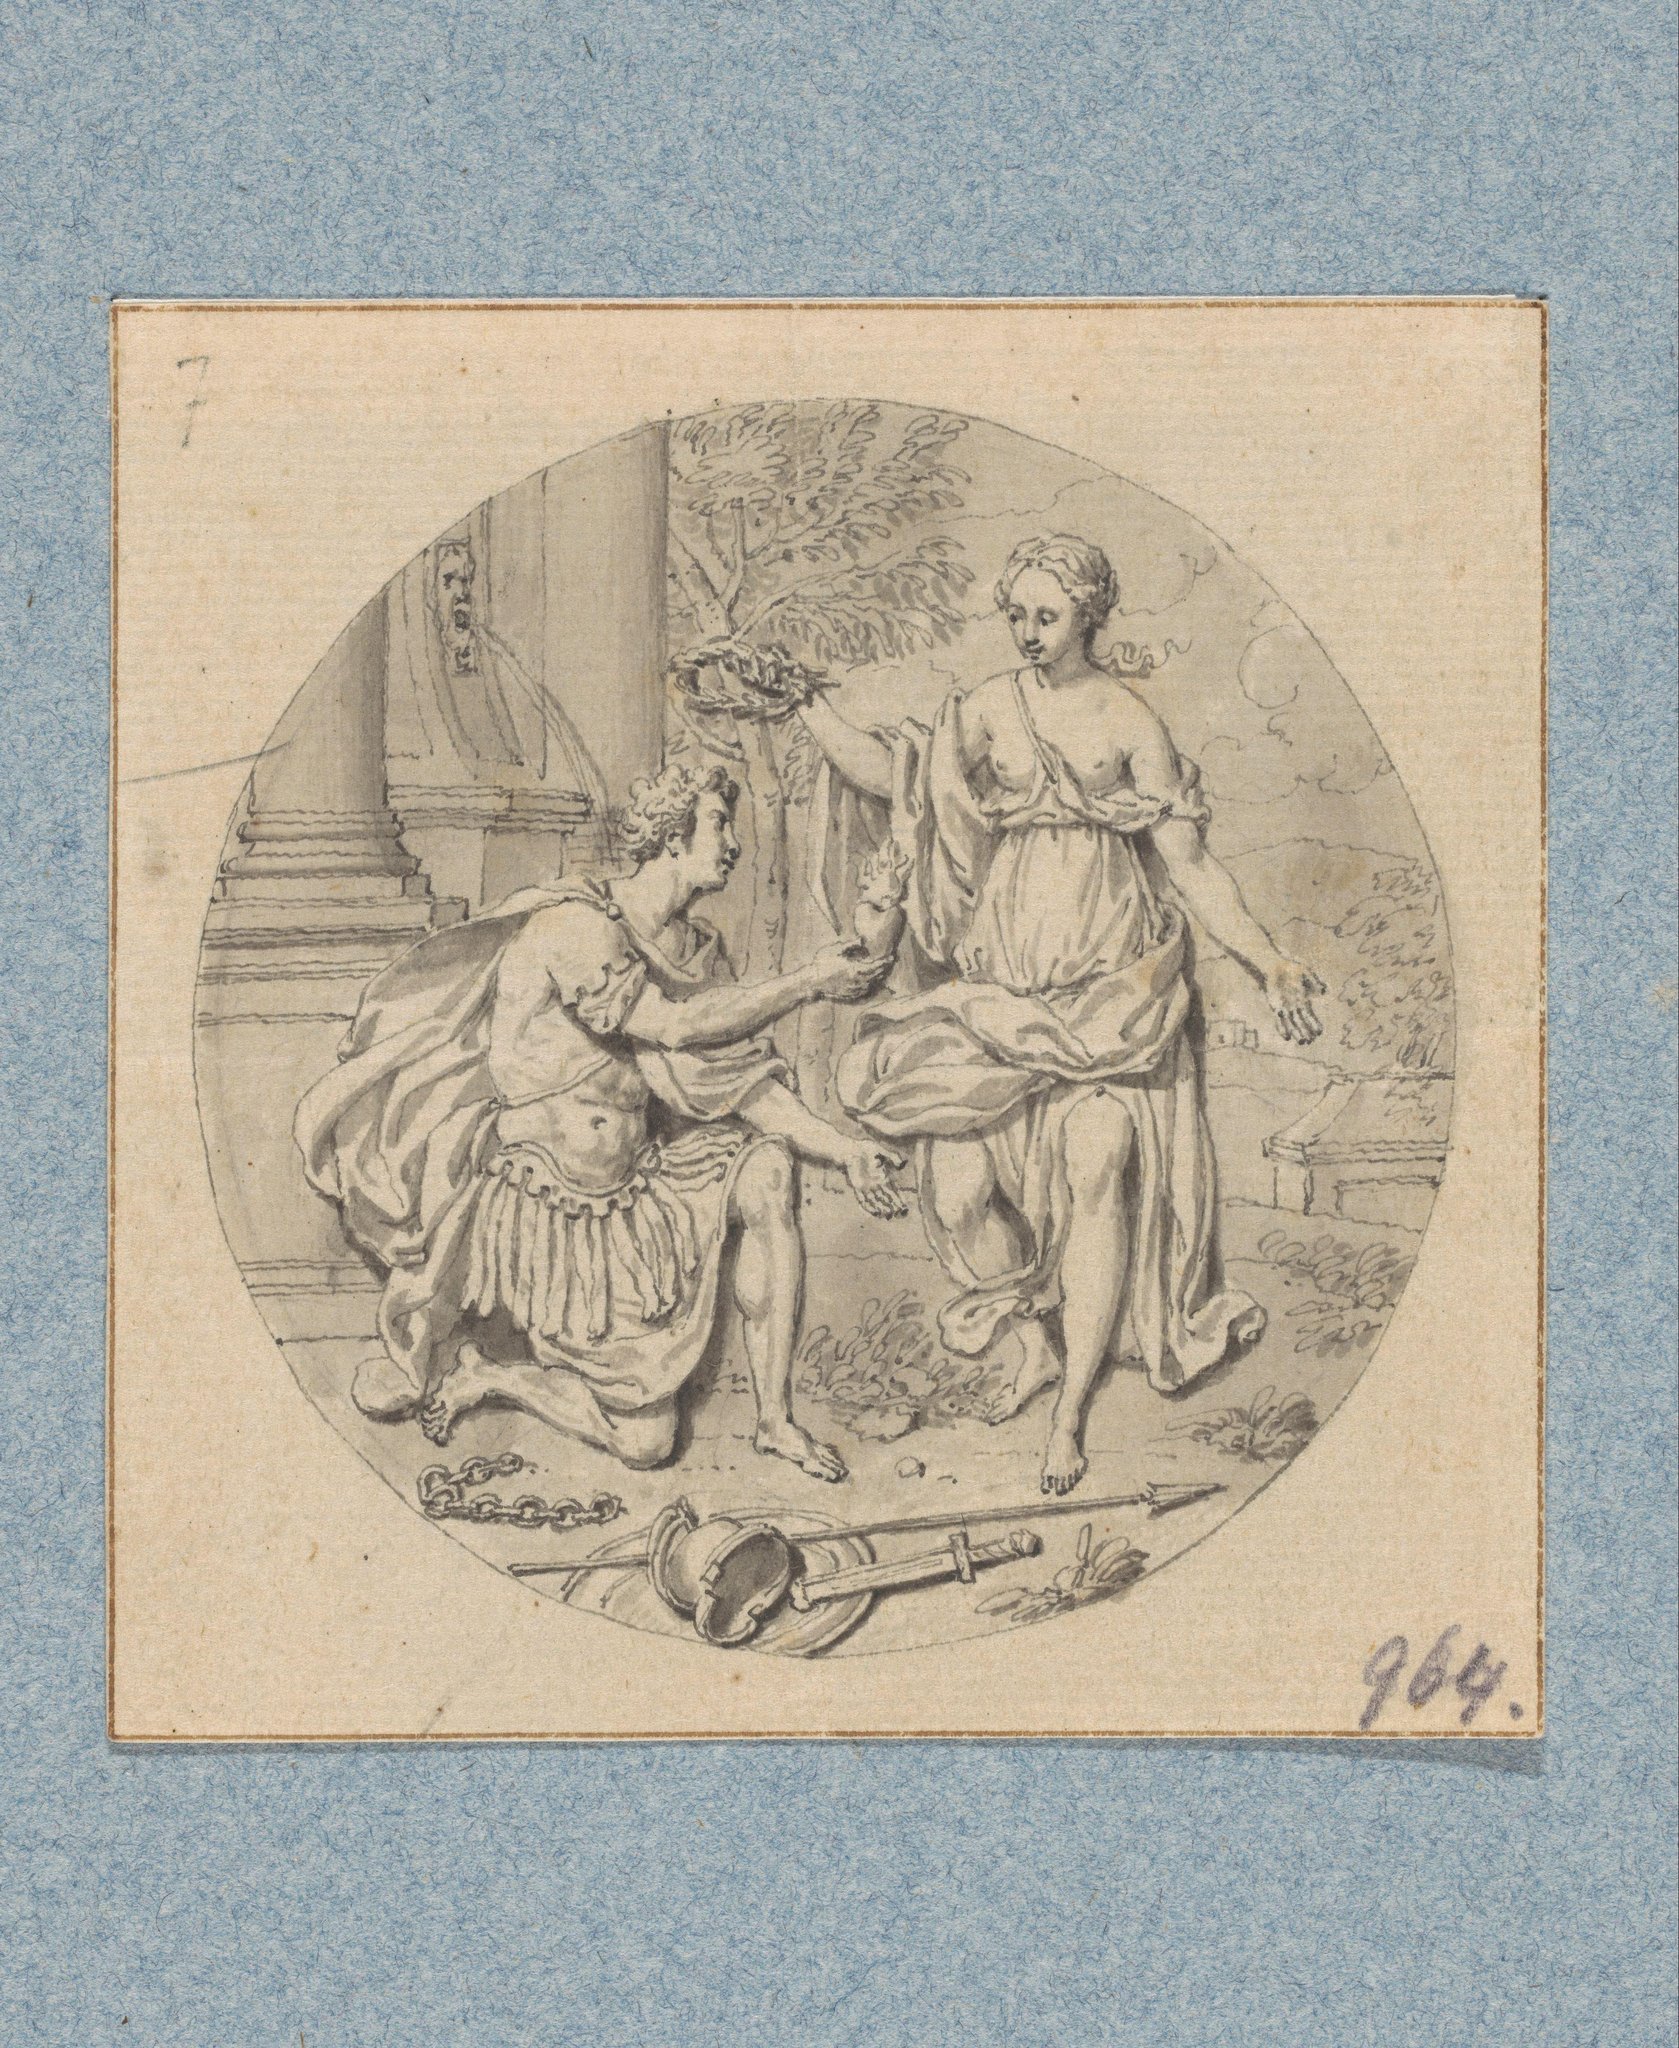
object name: drawing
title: Kroning van een militair (in doos met 43 tekeningen)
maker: louis fabritius dubourg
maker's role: draughtsman, print maker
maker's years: 1693-1775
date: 1703-1775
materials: ink, paper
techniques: brush, pen